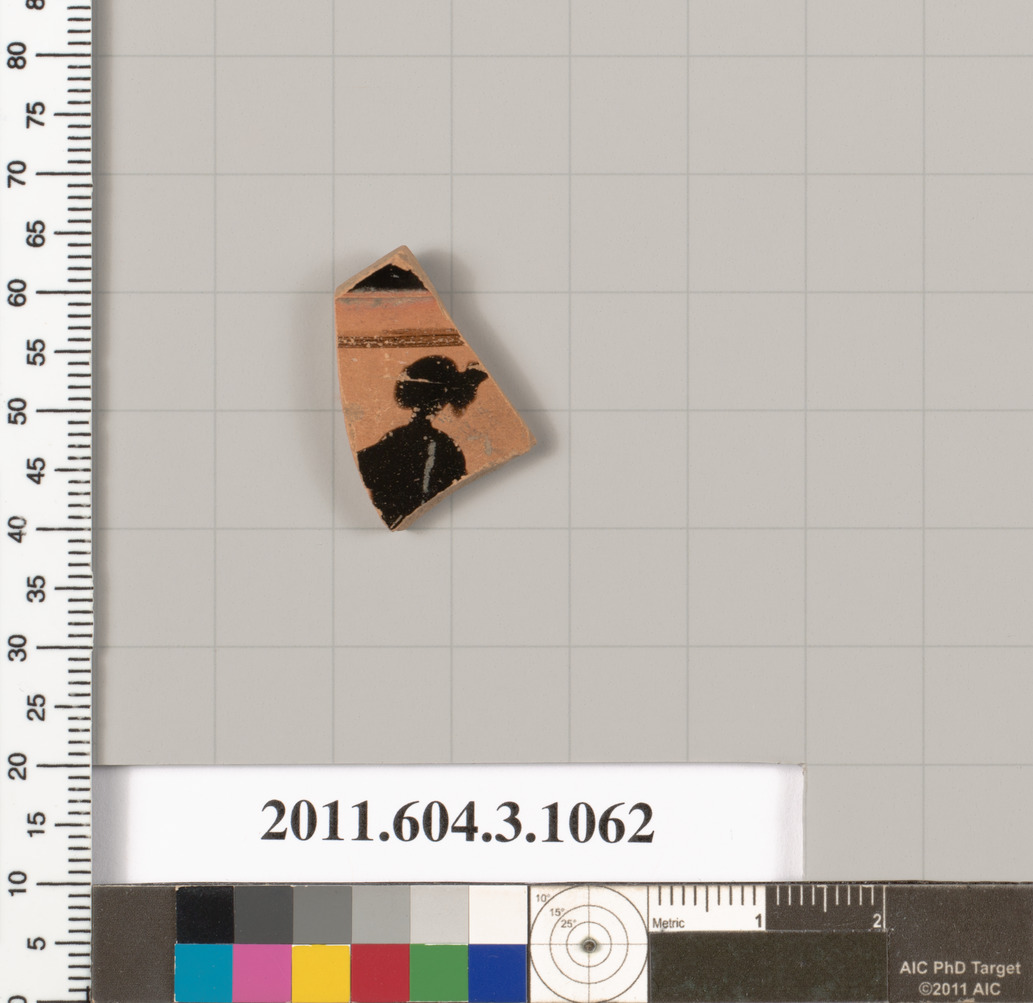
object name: mastoid fragment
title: Terracotta fragment of a mastoid (drinking cup with narrow base)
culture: greek, attic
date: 534-468 BCE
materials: terracotta